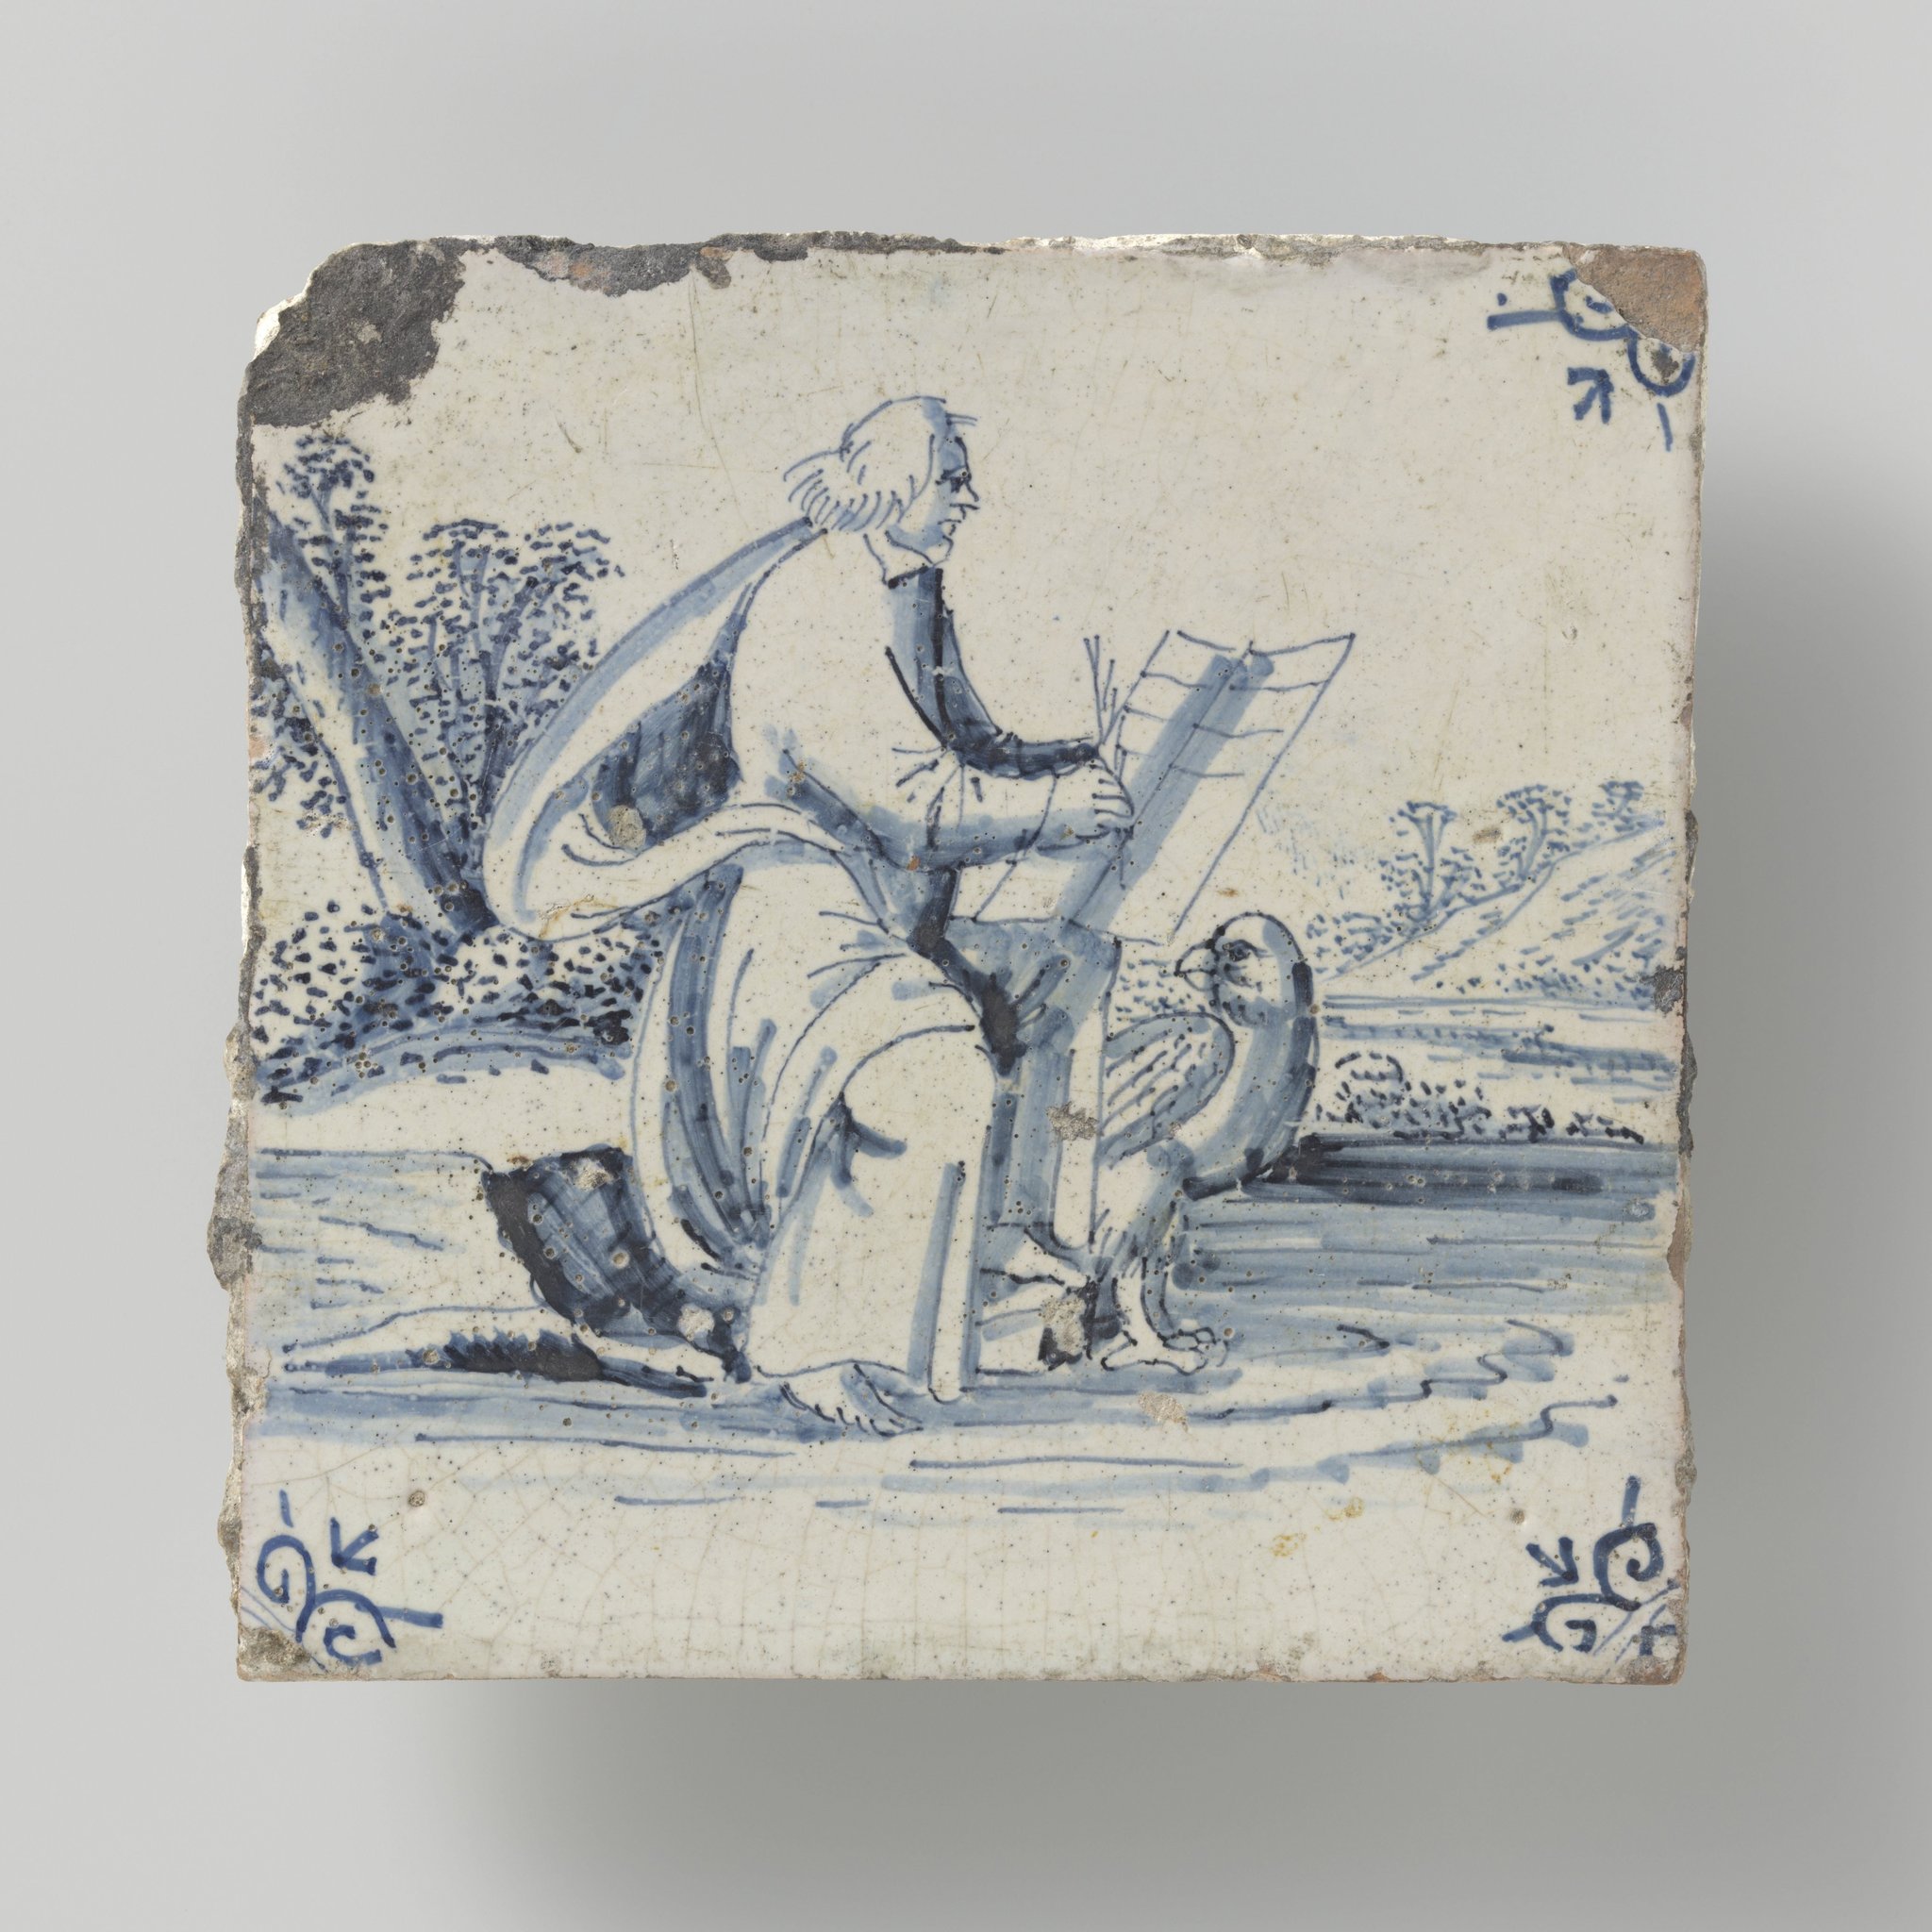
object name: bijbeltegel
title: Tegel met de evangelist Johannes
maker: Anonymous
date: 1620-1650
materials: earthenware, glaze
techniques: maiolica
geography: netherlands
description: Tegel met een blauw geschilderde bijbelse voorstelling van Johannes de evangelist met een geschrift en naast een adelaar. In de hoeken, een ossenkop.